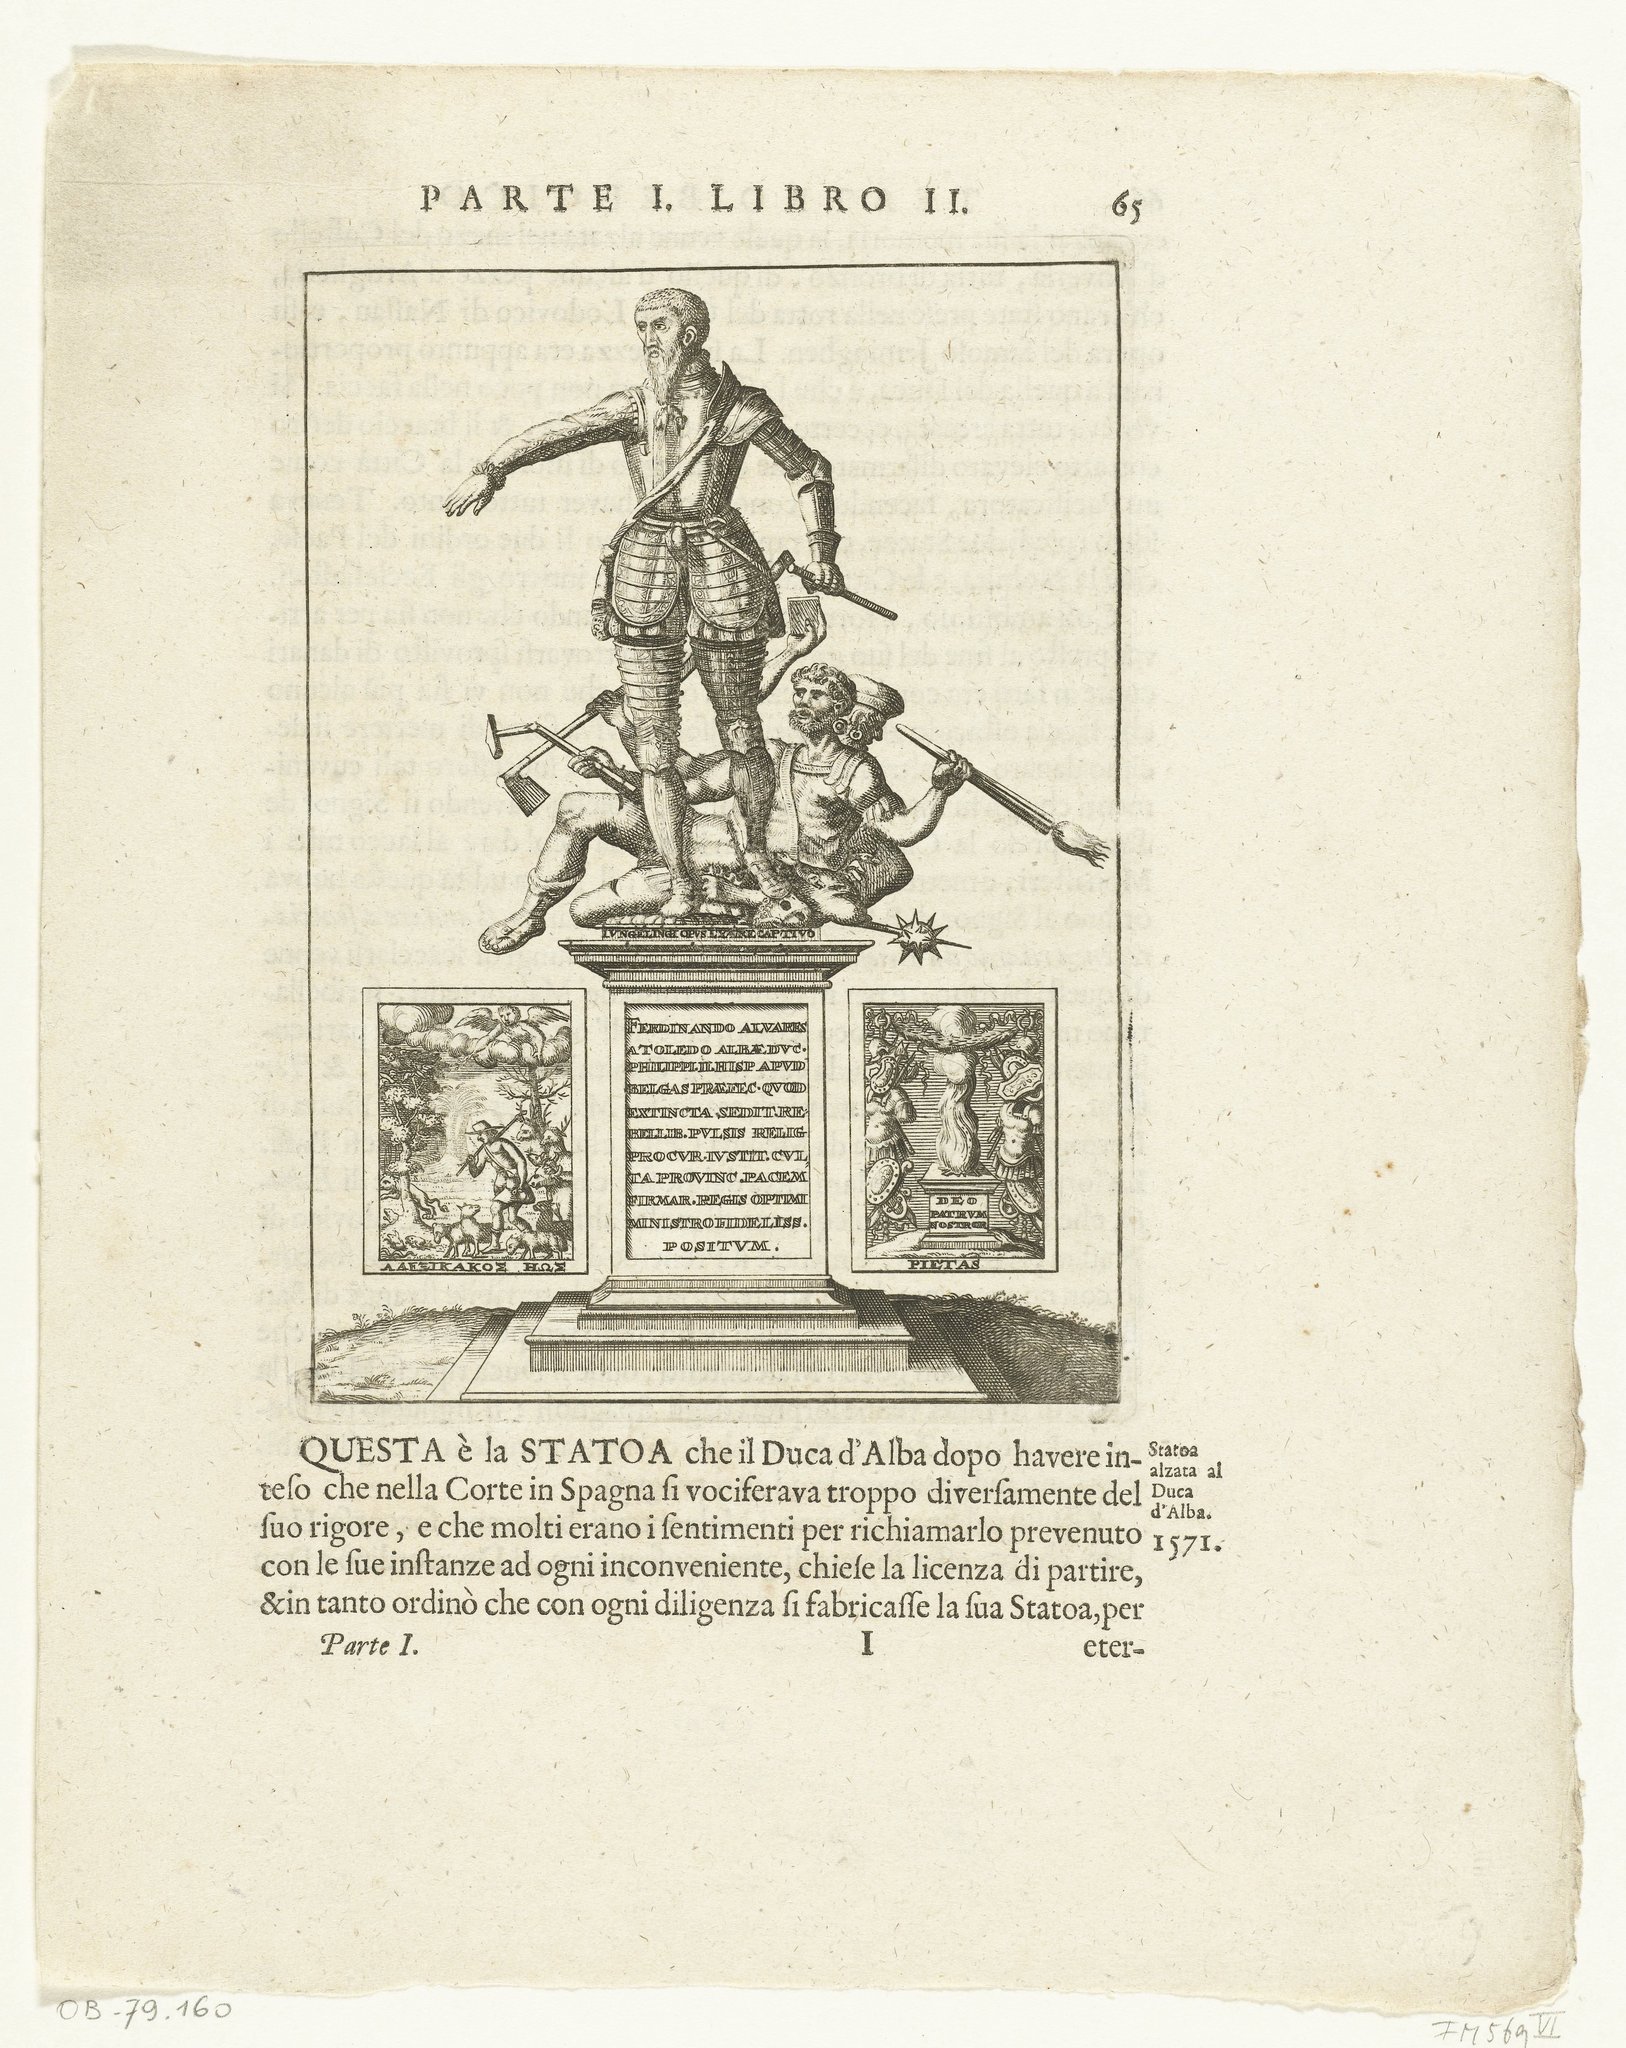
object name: historical object representation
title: Standbeeld van de hertog van Alva, 1571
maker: Anonymous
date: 1688-1690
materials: paper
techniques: engraving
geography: italy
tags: fernando álvarez de toledo (3rd duke of alba), piece of sculpture, reproduction of a piece of sculpture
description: Het standbeeld van de hertog van Alva, door hemzelf opgericht op de binnenplaats van de citadel te Antwerpen, 1571. Met de twee voorstellingen op de zijden van het voetstuk. Bladzijde uit een Italiaans boek, met tekst onder de plaat en op de achterzijde.